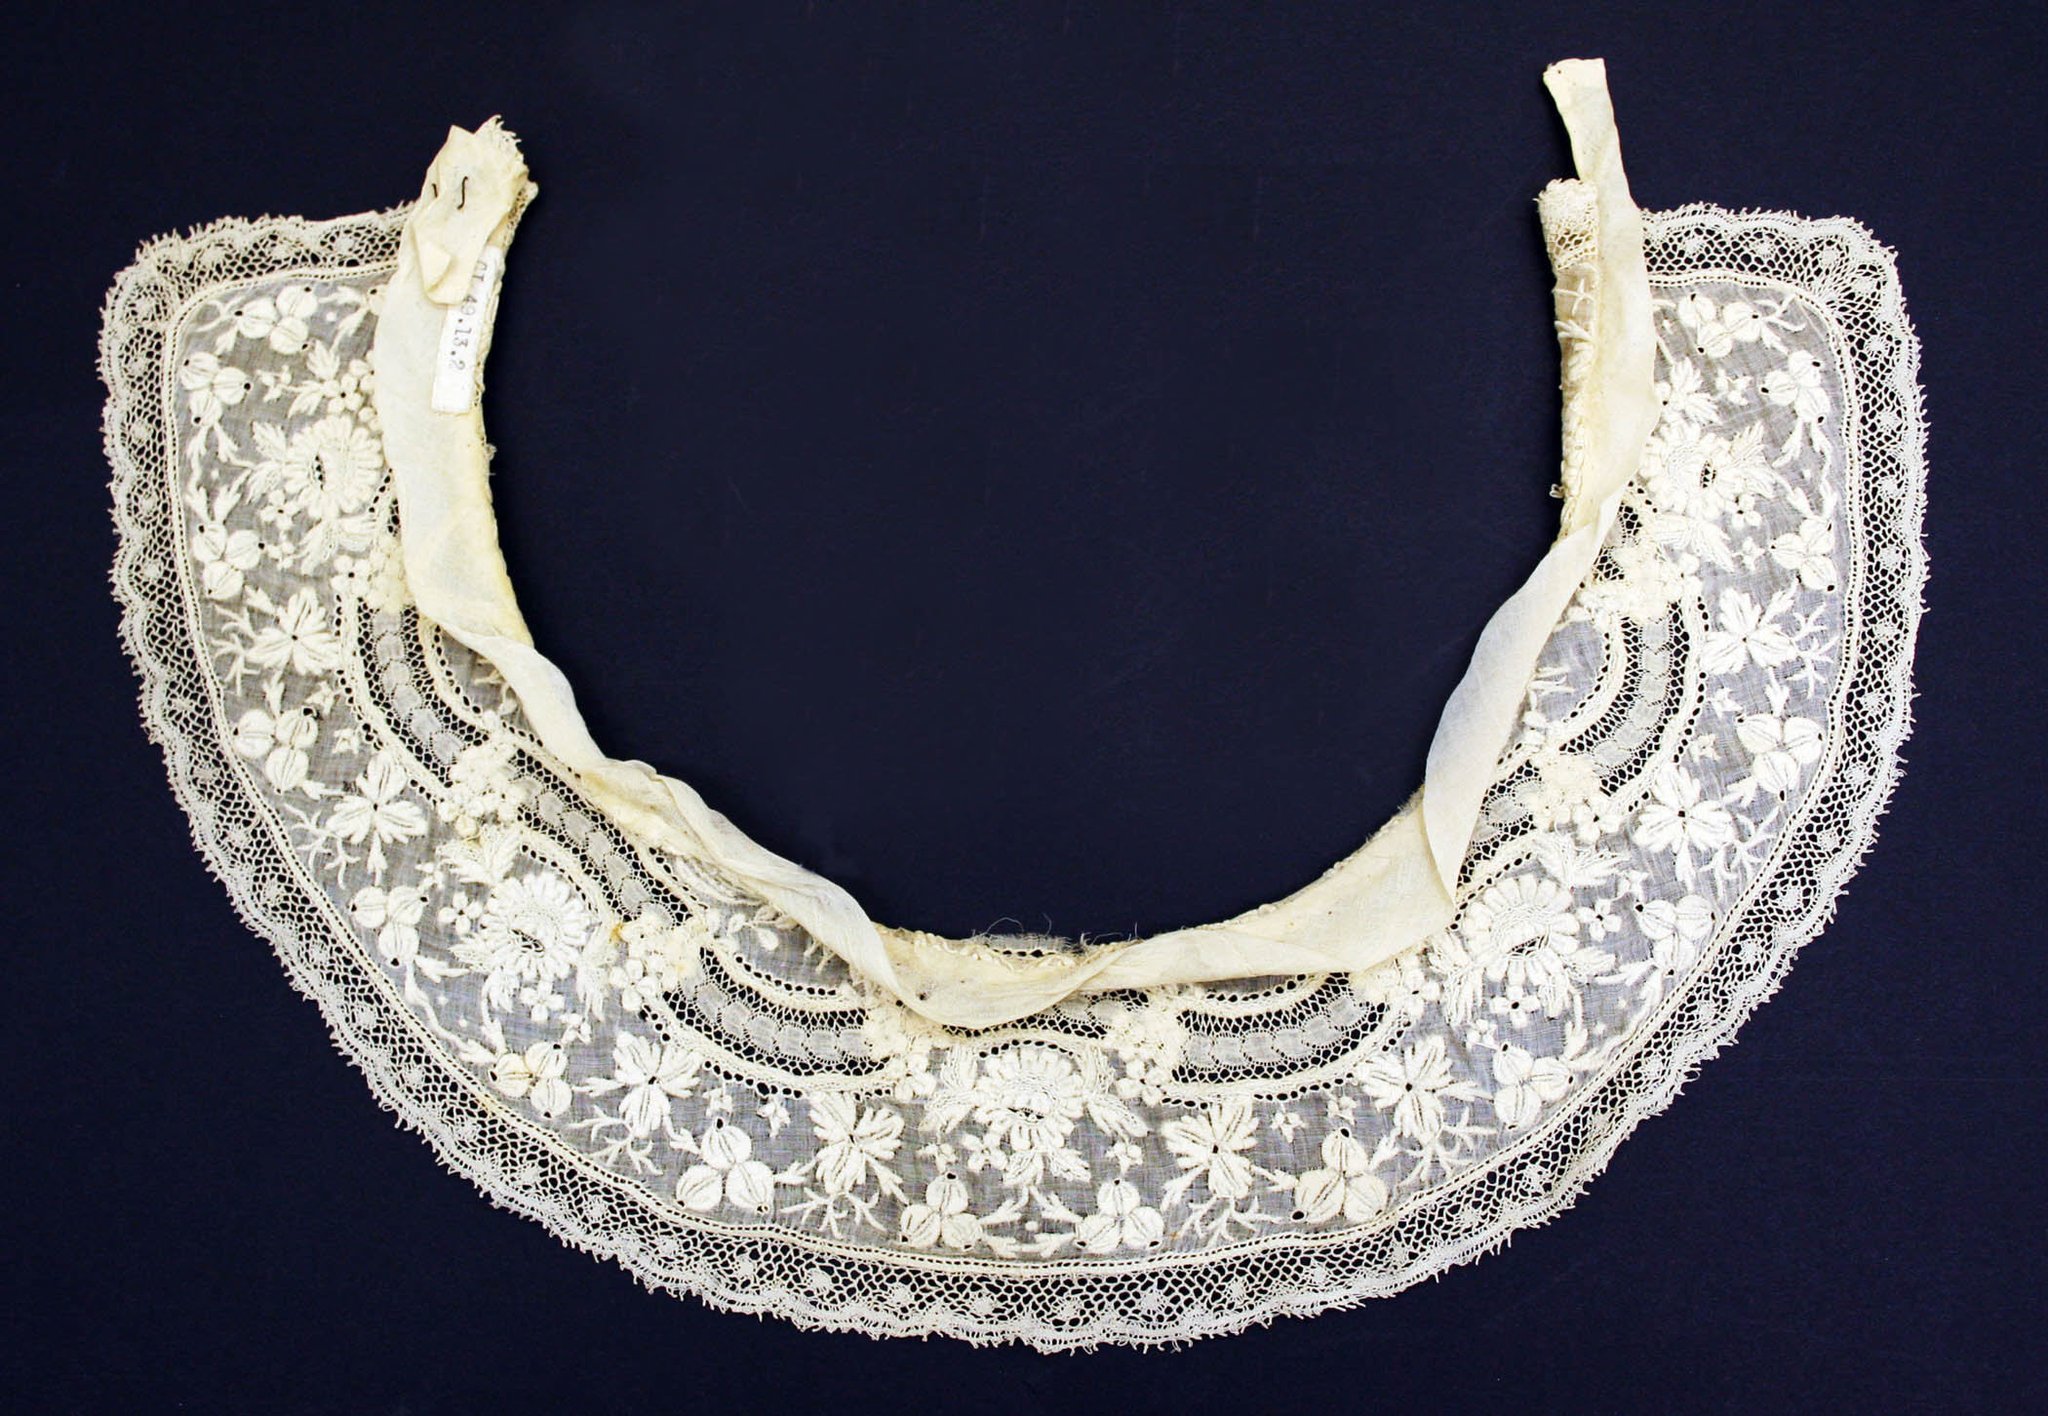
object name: collar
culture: american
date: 1850-1869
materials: cotton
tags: flowers